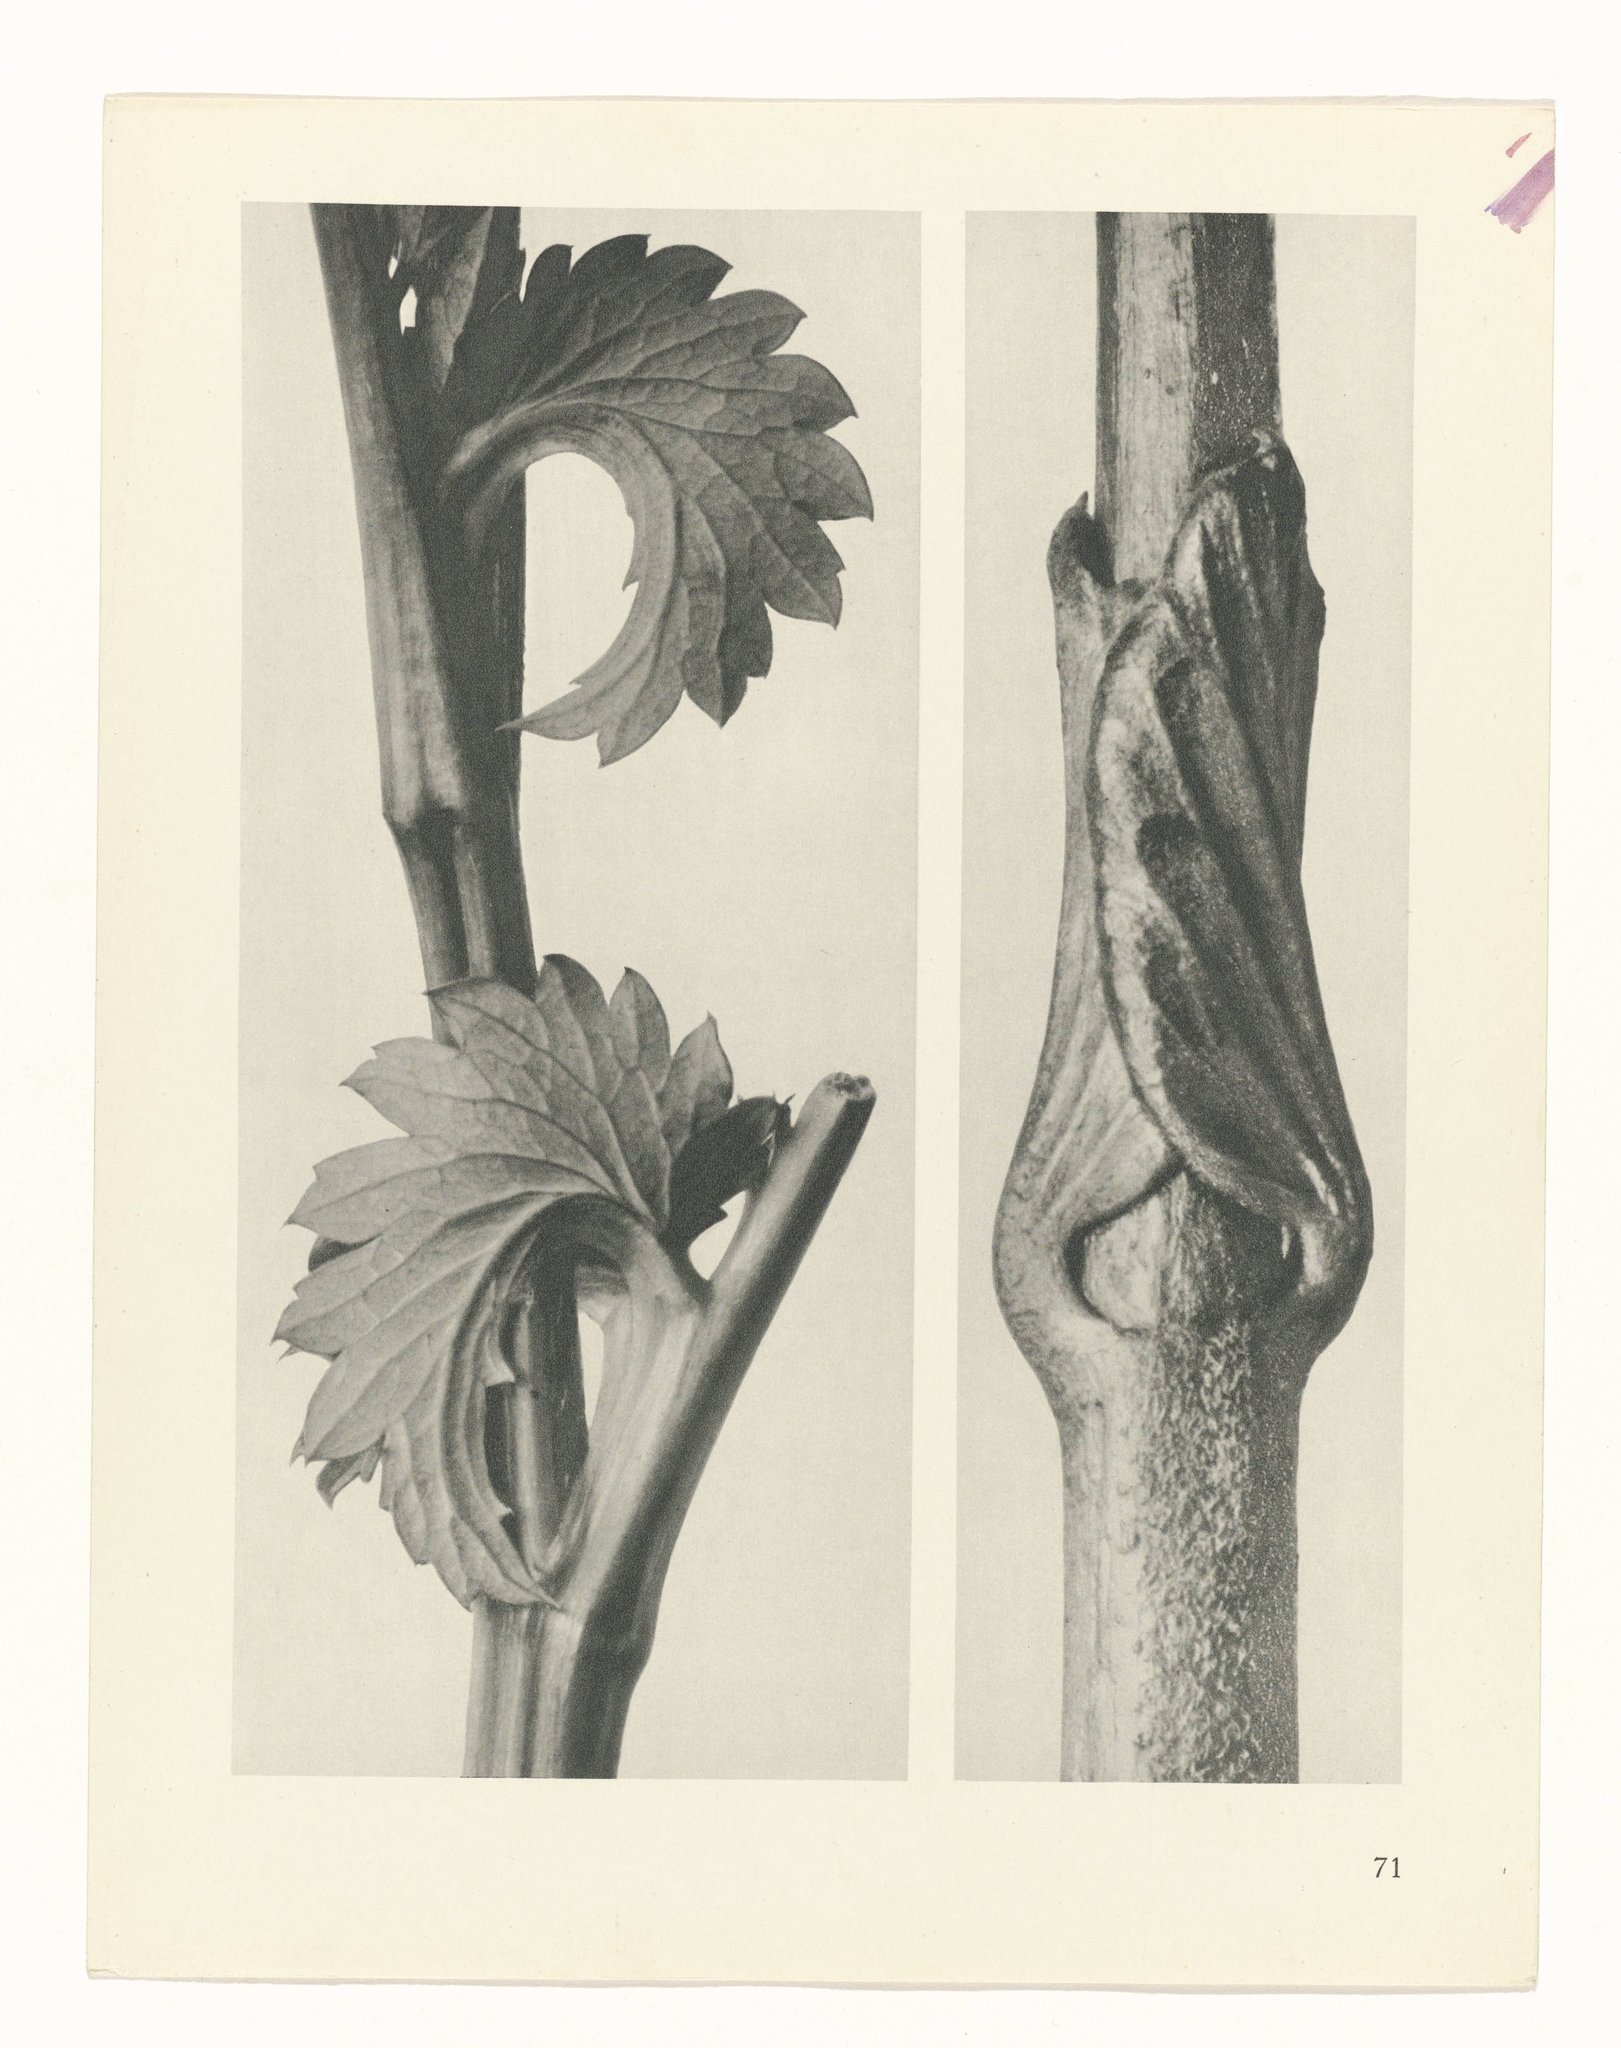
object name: photograph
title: Plantstudie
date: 1928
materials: ink, paper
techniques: rotogravure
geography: berlin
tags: plants (in general)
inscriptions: number: ‘71’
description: facher Vergrößerung. Afkomstig uit losbladige uitgave.